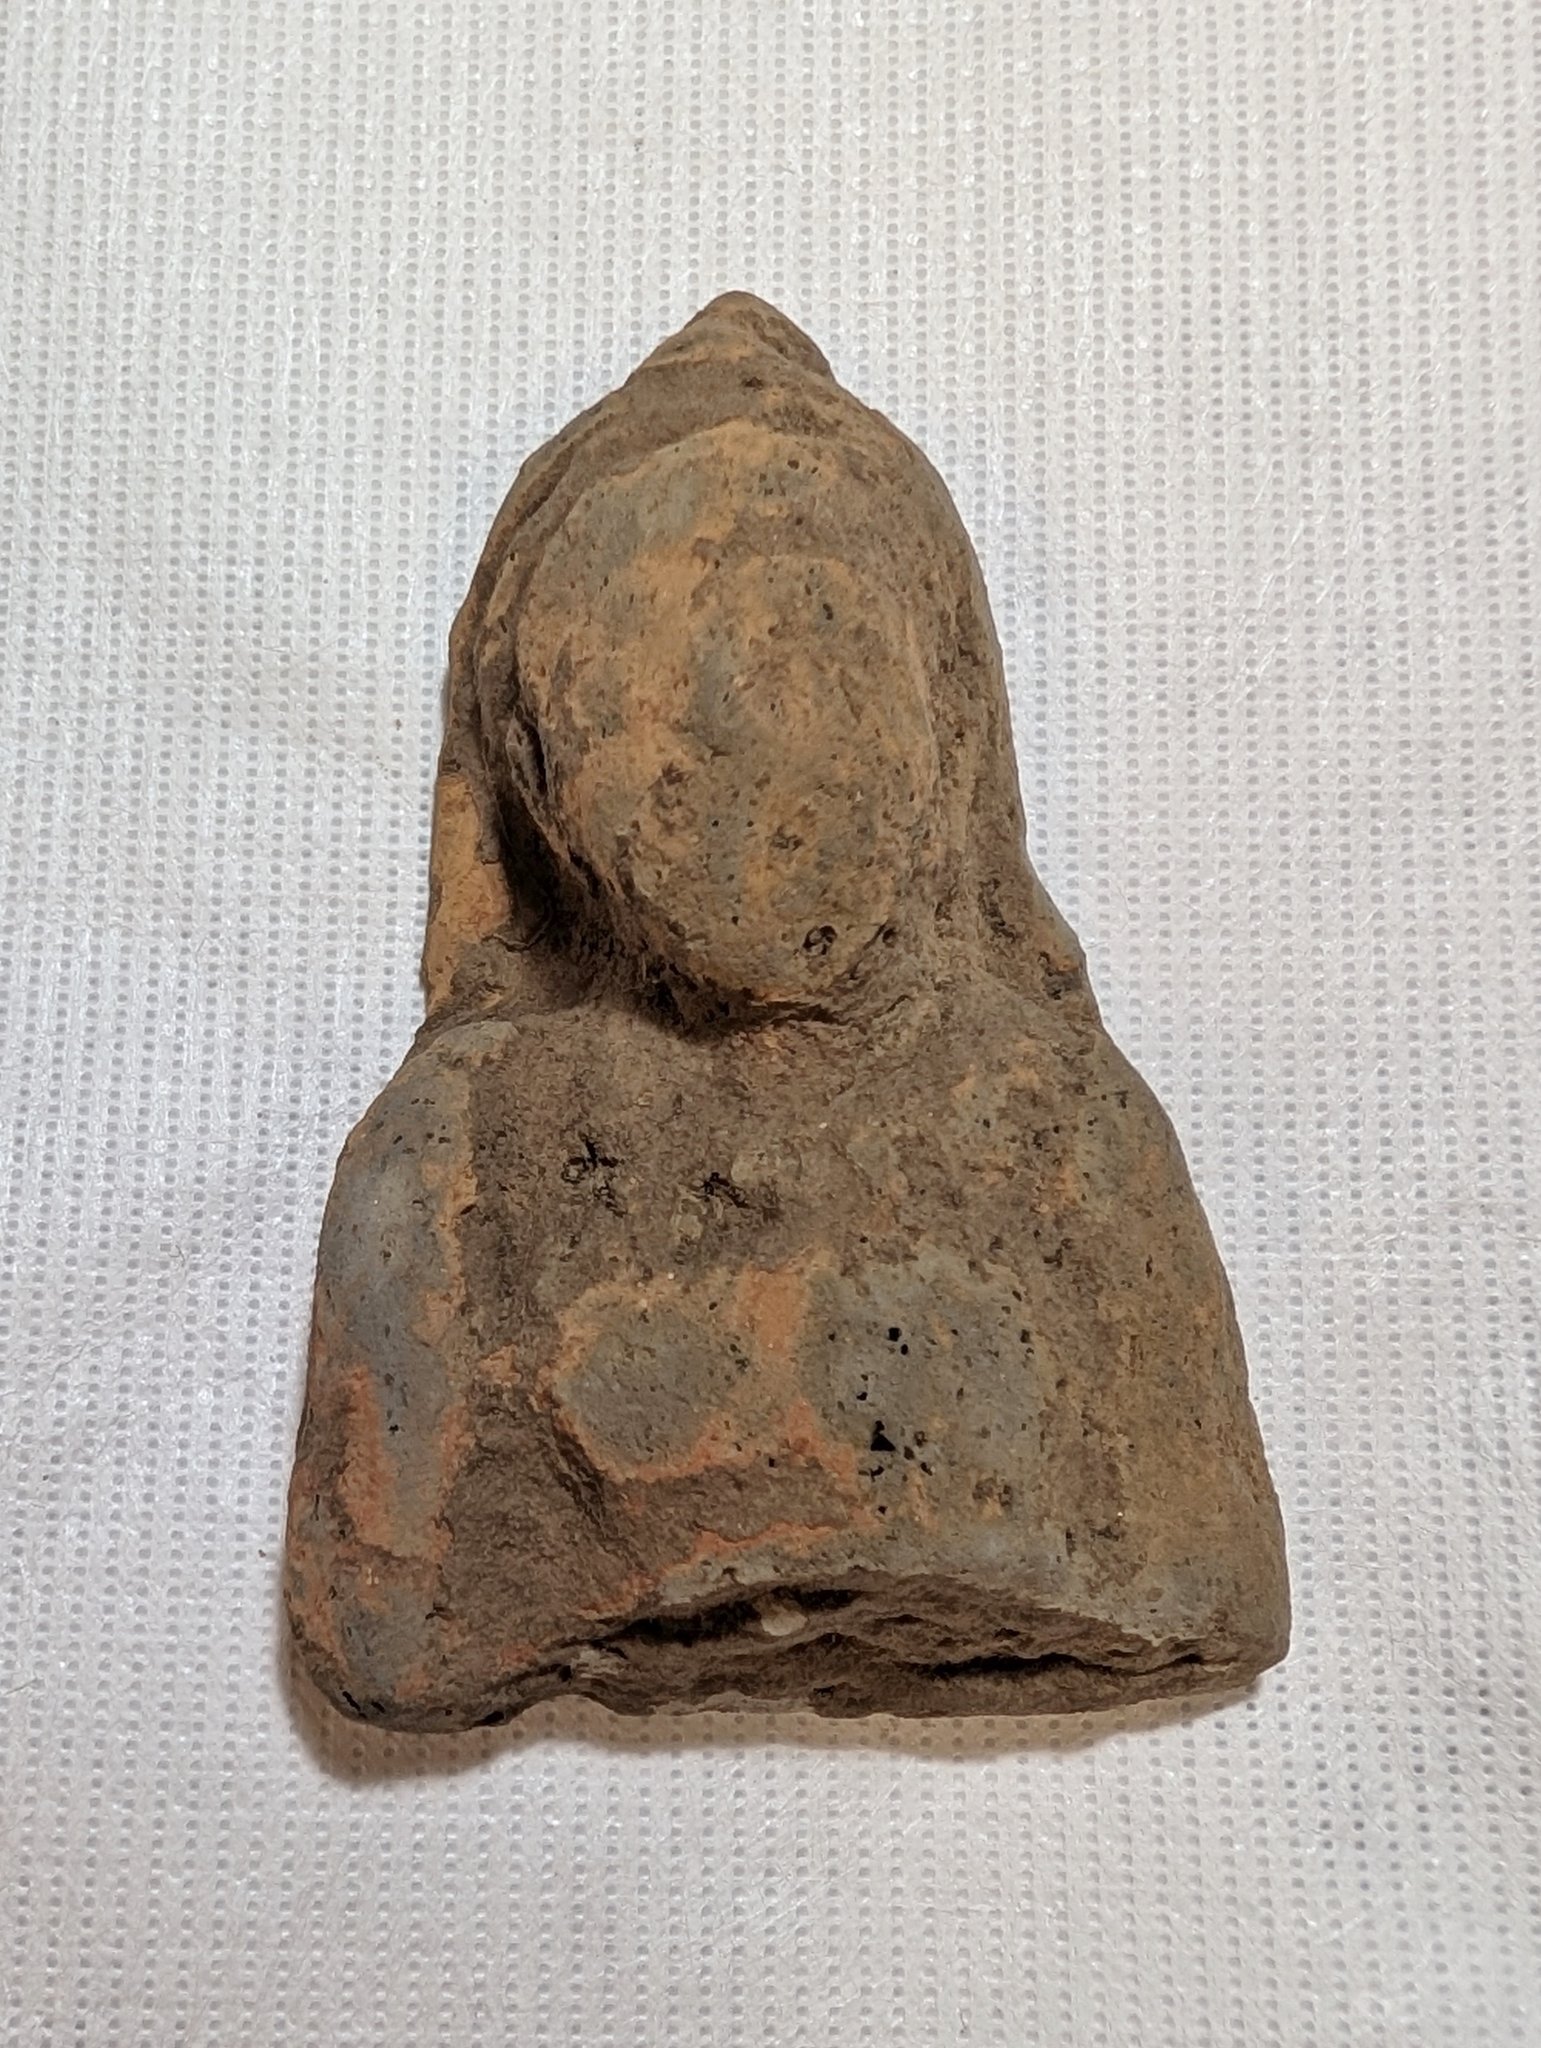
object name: plaque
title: Plaque in the Form of a Female Figure (Study Collection)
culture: pakistani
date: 101-300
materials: terracotta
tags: gandhara